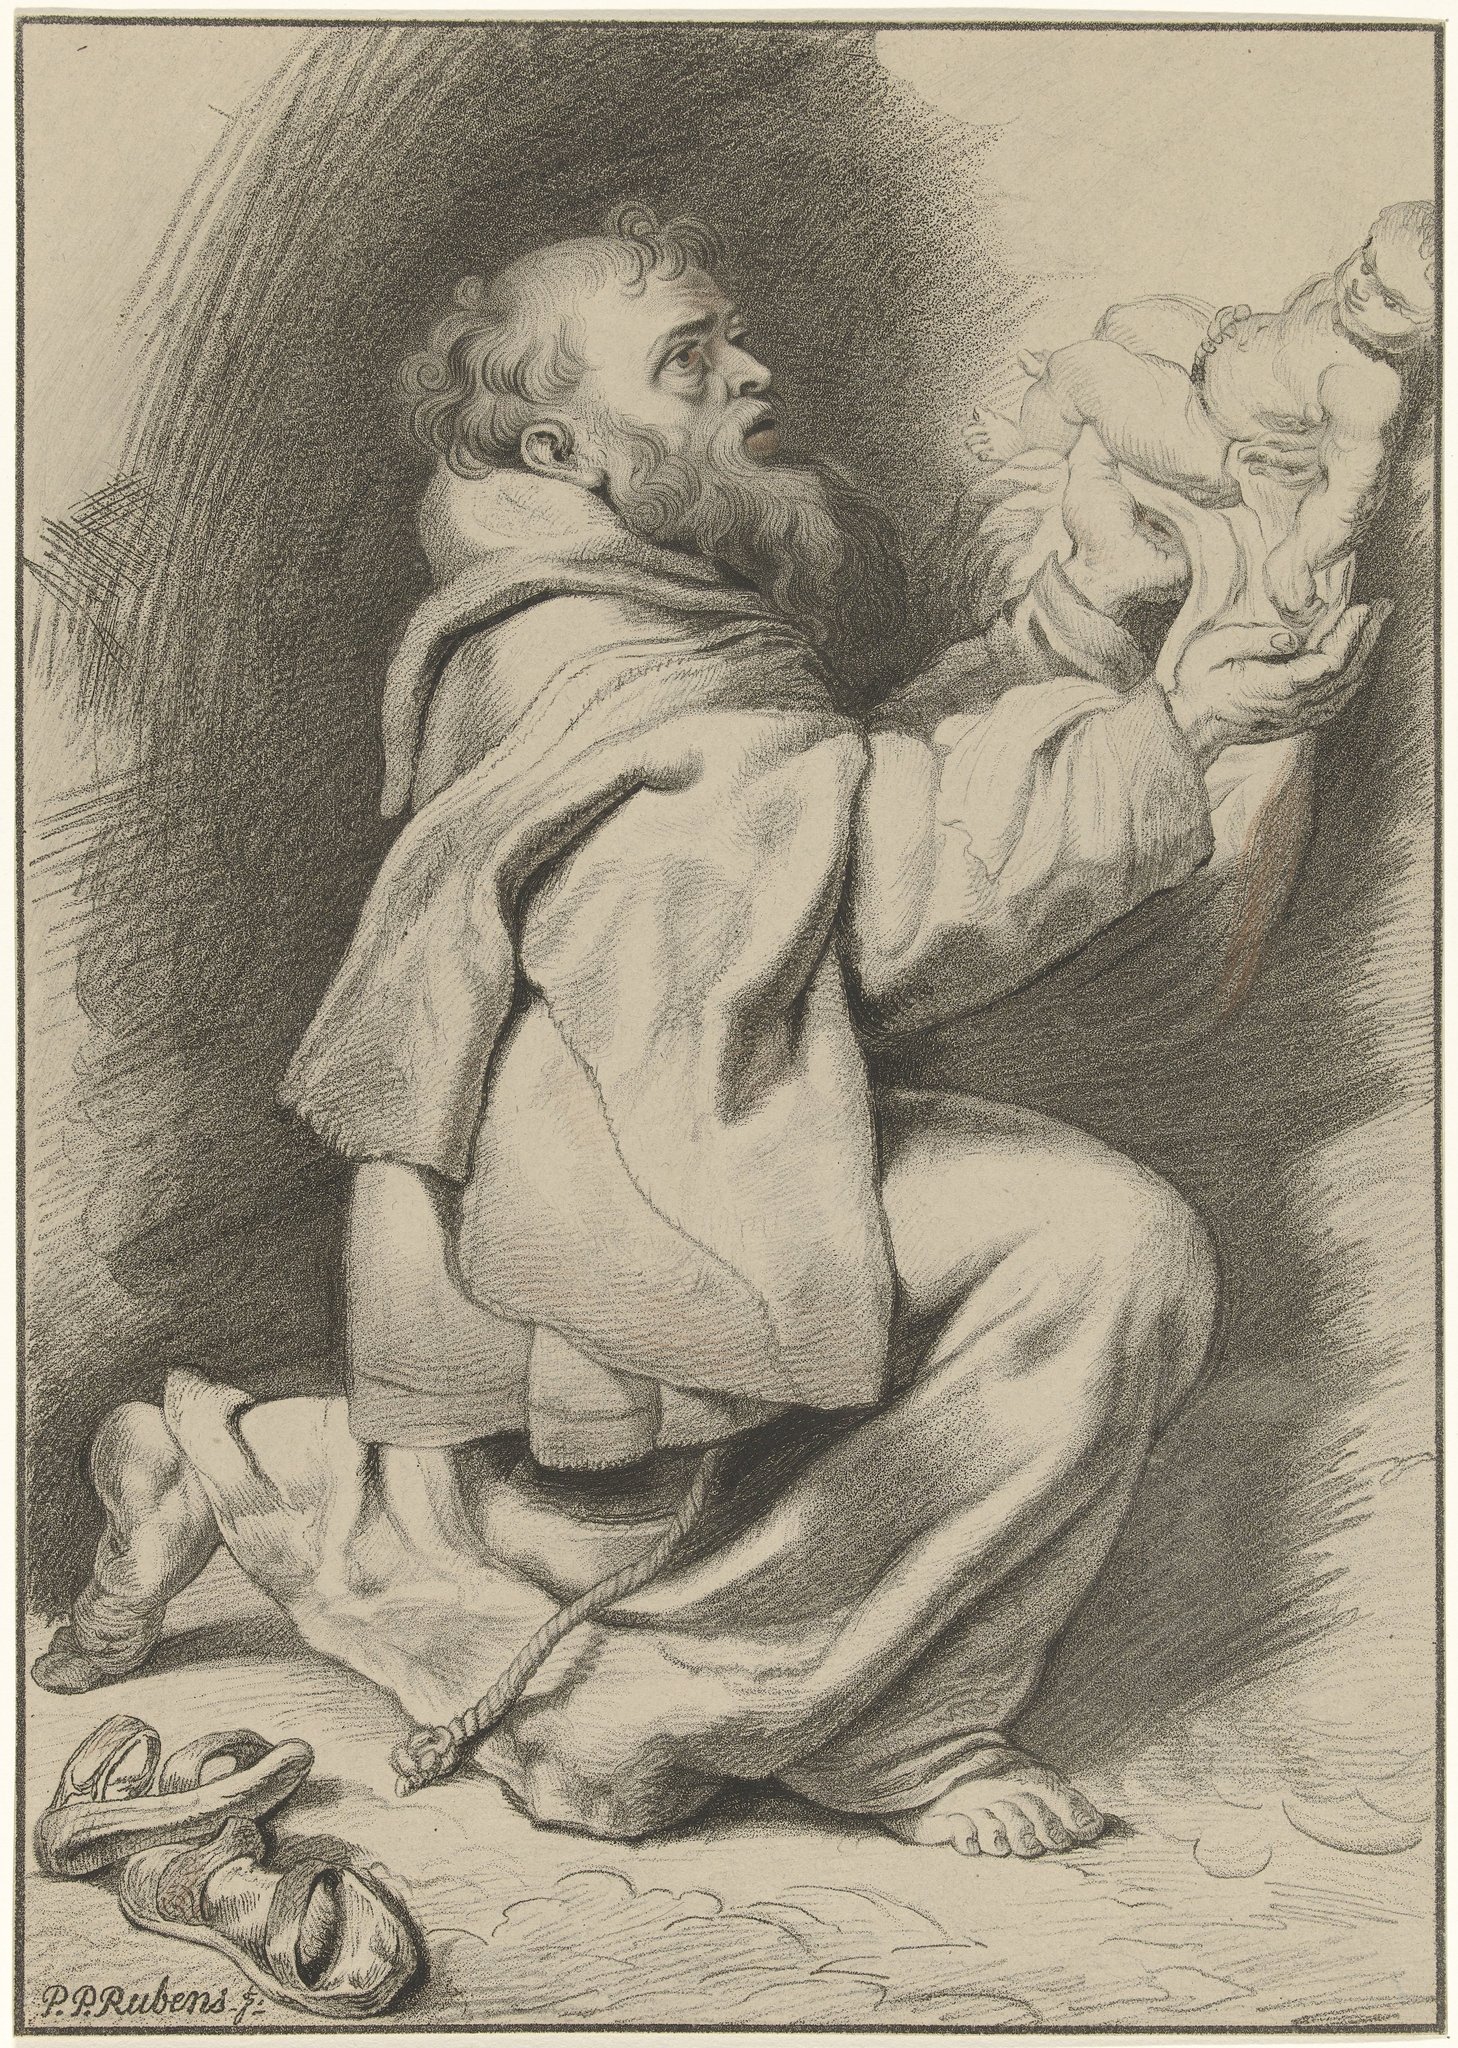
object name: print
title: Heilige Franciscus van Assisi ontvangt het Christuskind van Maria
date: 1821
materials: paper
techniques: printmaking, hand coloring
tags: the virgin mary handing over the infant christ to st. francis of assisi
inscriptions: collector's mark: Lugt 2725, collector's mark: Lugt 12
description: Door Christiaan Josi opgenomen in een uitgave met 100 werken naar Hollandse en Vlaamse meesters: Collection d'imitations de dessins d'après les principaux maîtres hollandais et flamands, Londen, C.Josi, 1821. Alle prenten in deze uitgave dragen op het verso het wapen van Cornelis Ploos van Amstel, de initiatiefnemer voor de uitgave.